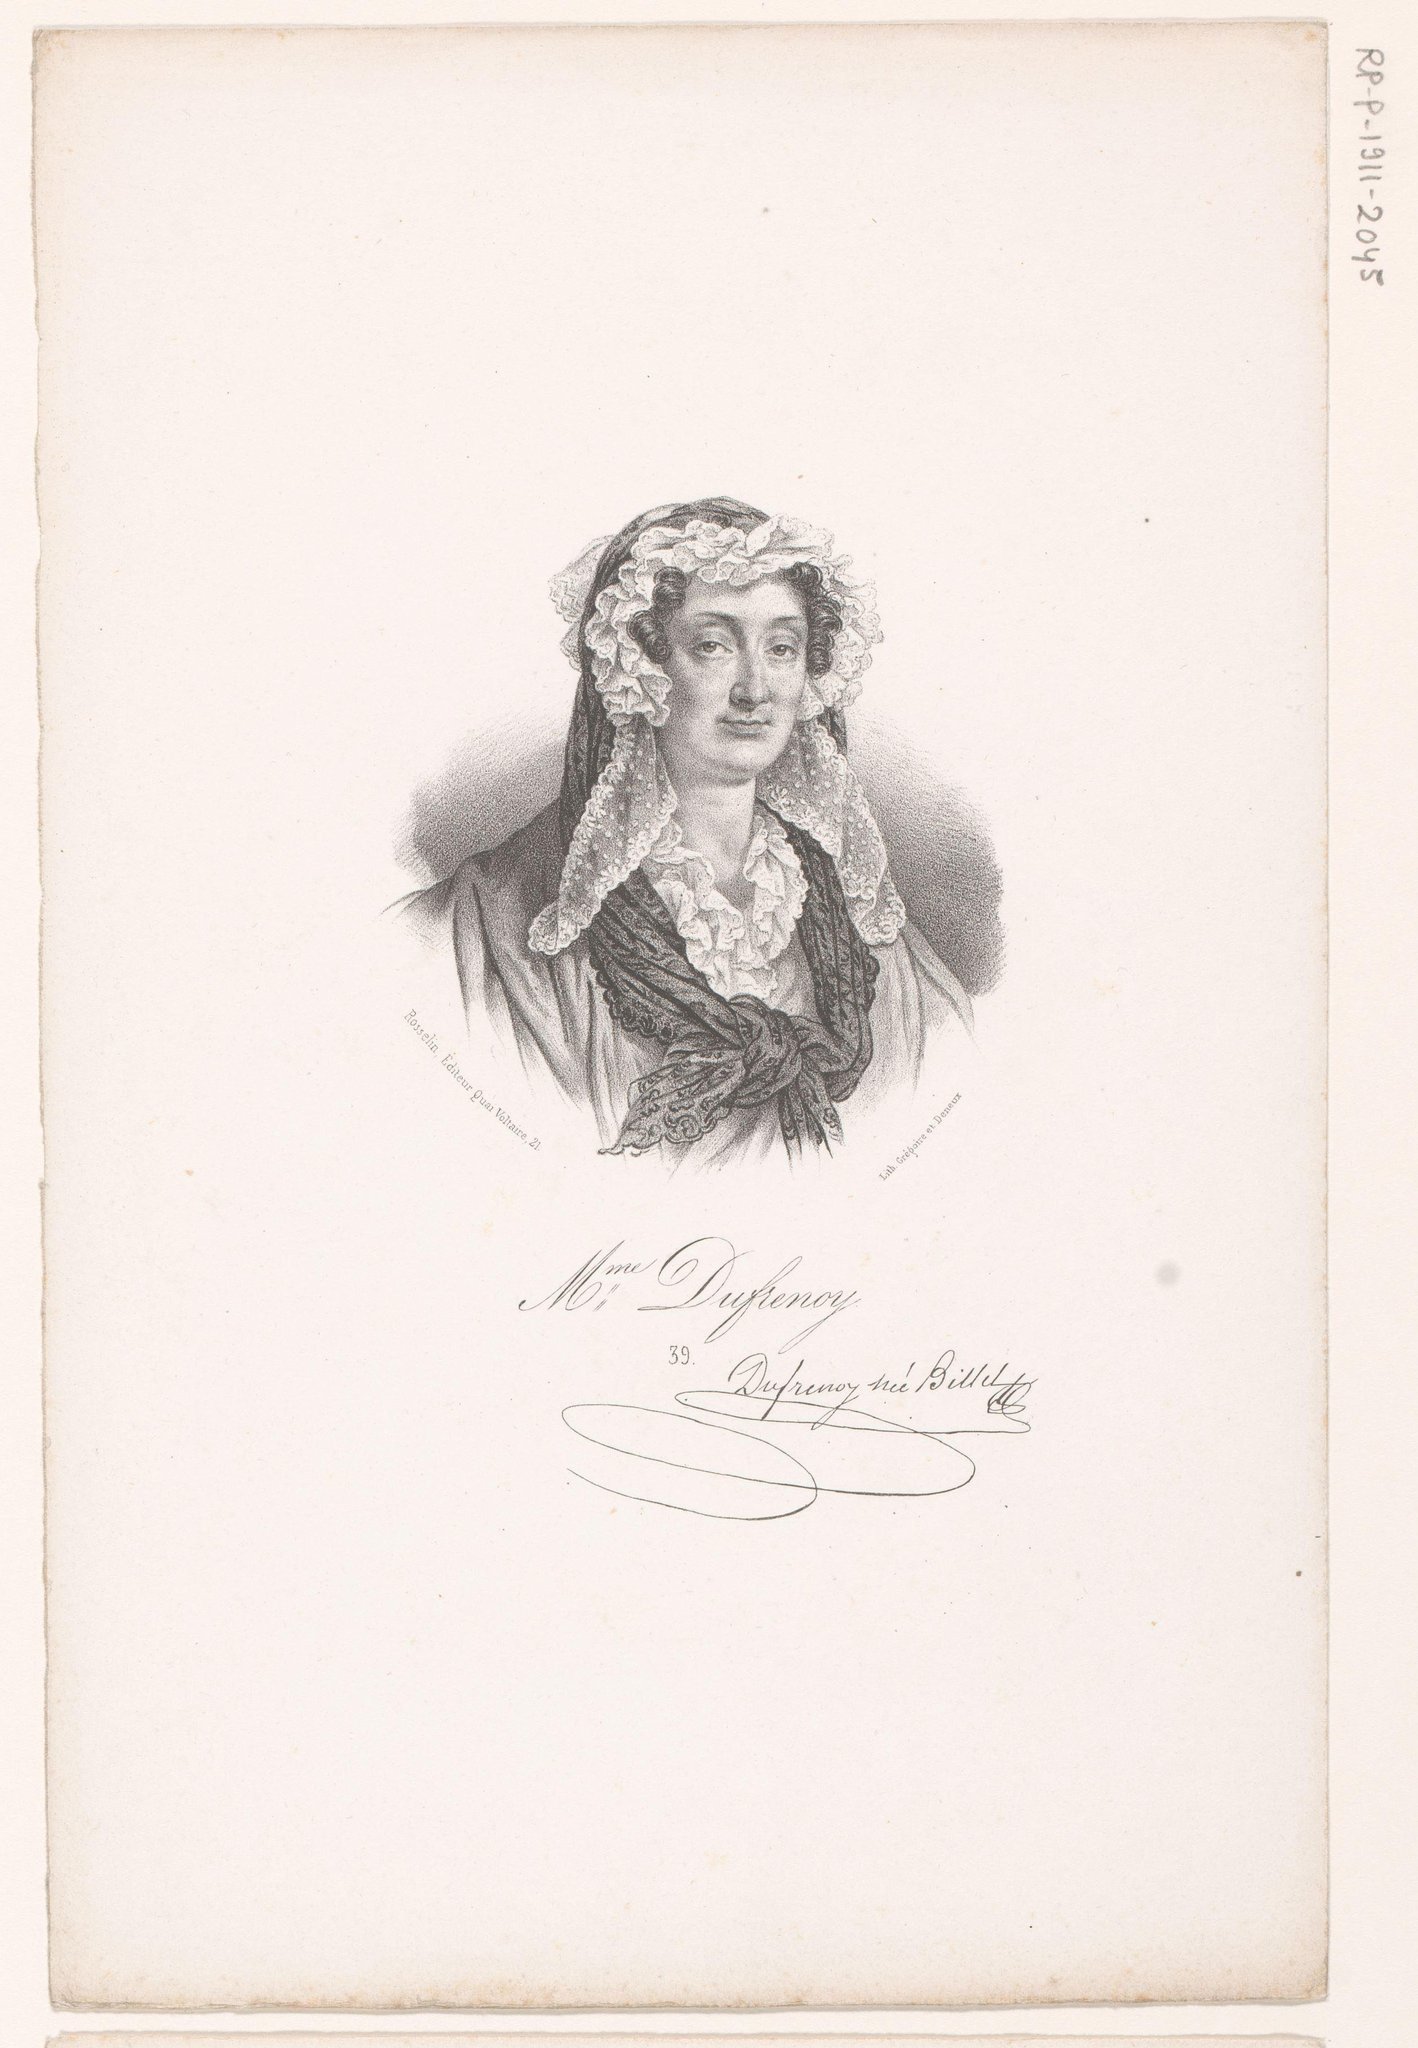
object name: print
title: Portret van Adélaïde-Gillette Dufrénoy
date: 1844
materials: paper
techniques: lithograph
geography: paris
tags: paris, historical persons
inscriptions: collector's mark: Lugt 2228a